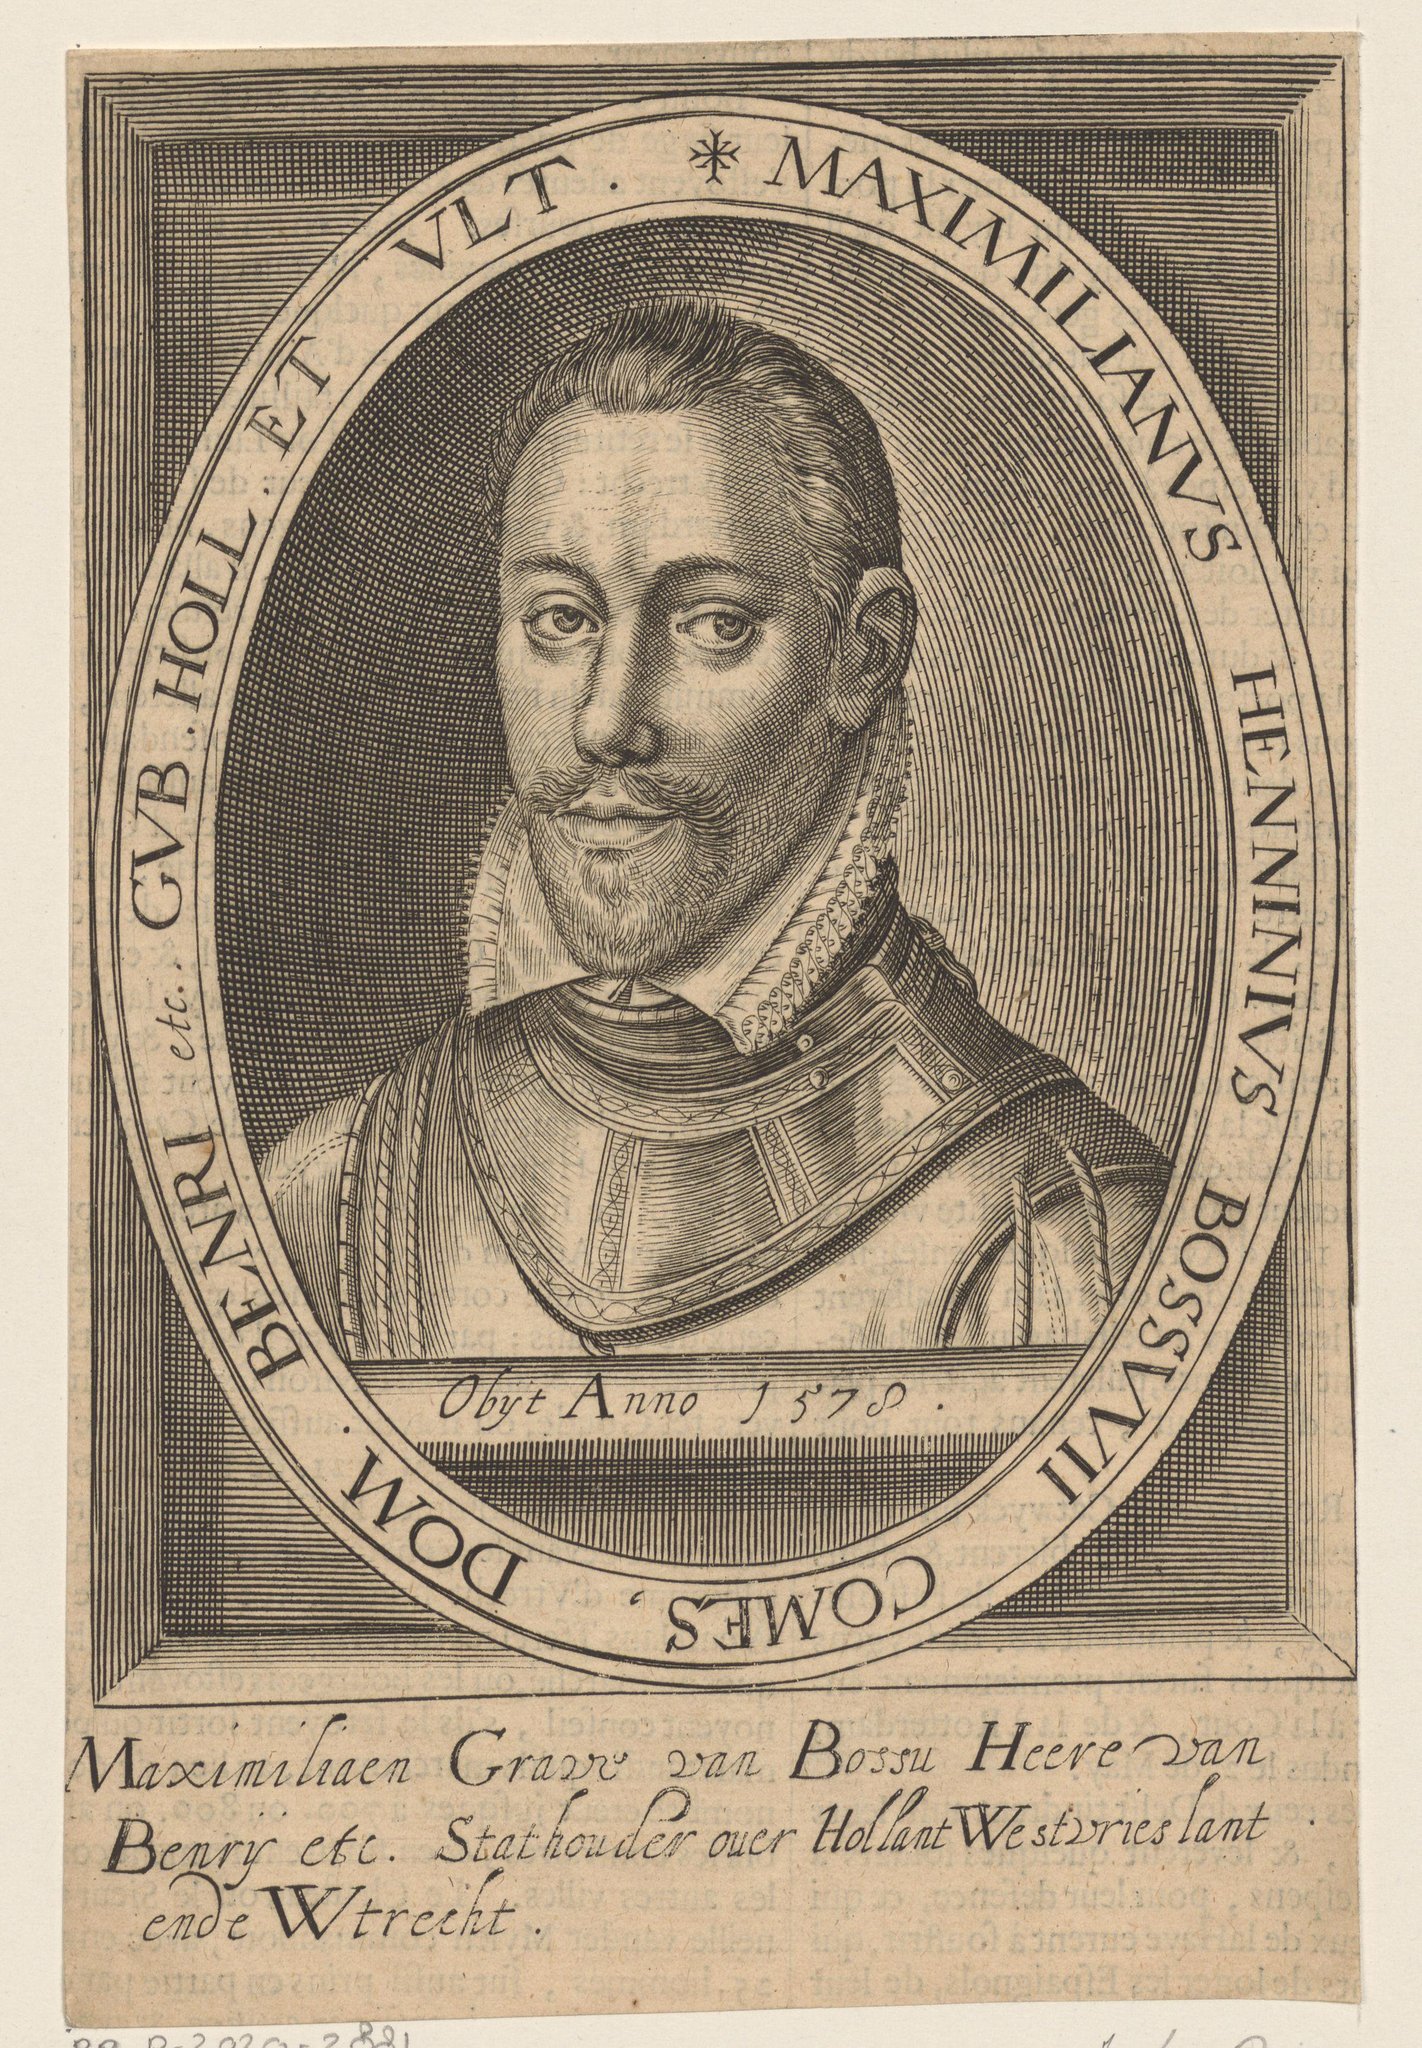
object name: book illustration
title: Portret van Maximiliaan, graaf van Hennin-Lietard en Boussu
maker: Anonymous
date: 1618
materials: paper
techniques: engraving, letterpress printing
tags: antwerp, earl, armour, historical persons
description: Prent uit: Meteren, Emanuel van. L'histoire des Pays-Bas (...) ou recueil des guerres, et choses memorables advenues tant és dits pays (...). Den Haag: Hillebrant Jacobsz. van Wouw (I), 1618. Boek opnieuw uitgegeven in 1670 met enkel een ander impressum op de titelpagina.